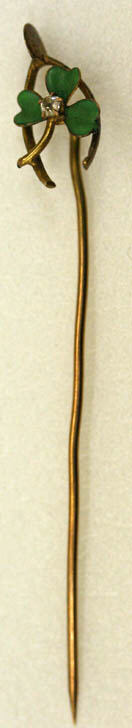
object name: pin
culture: american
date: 1891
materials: enamel, metal